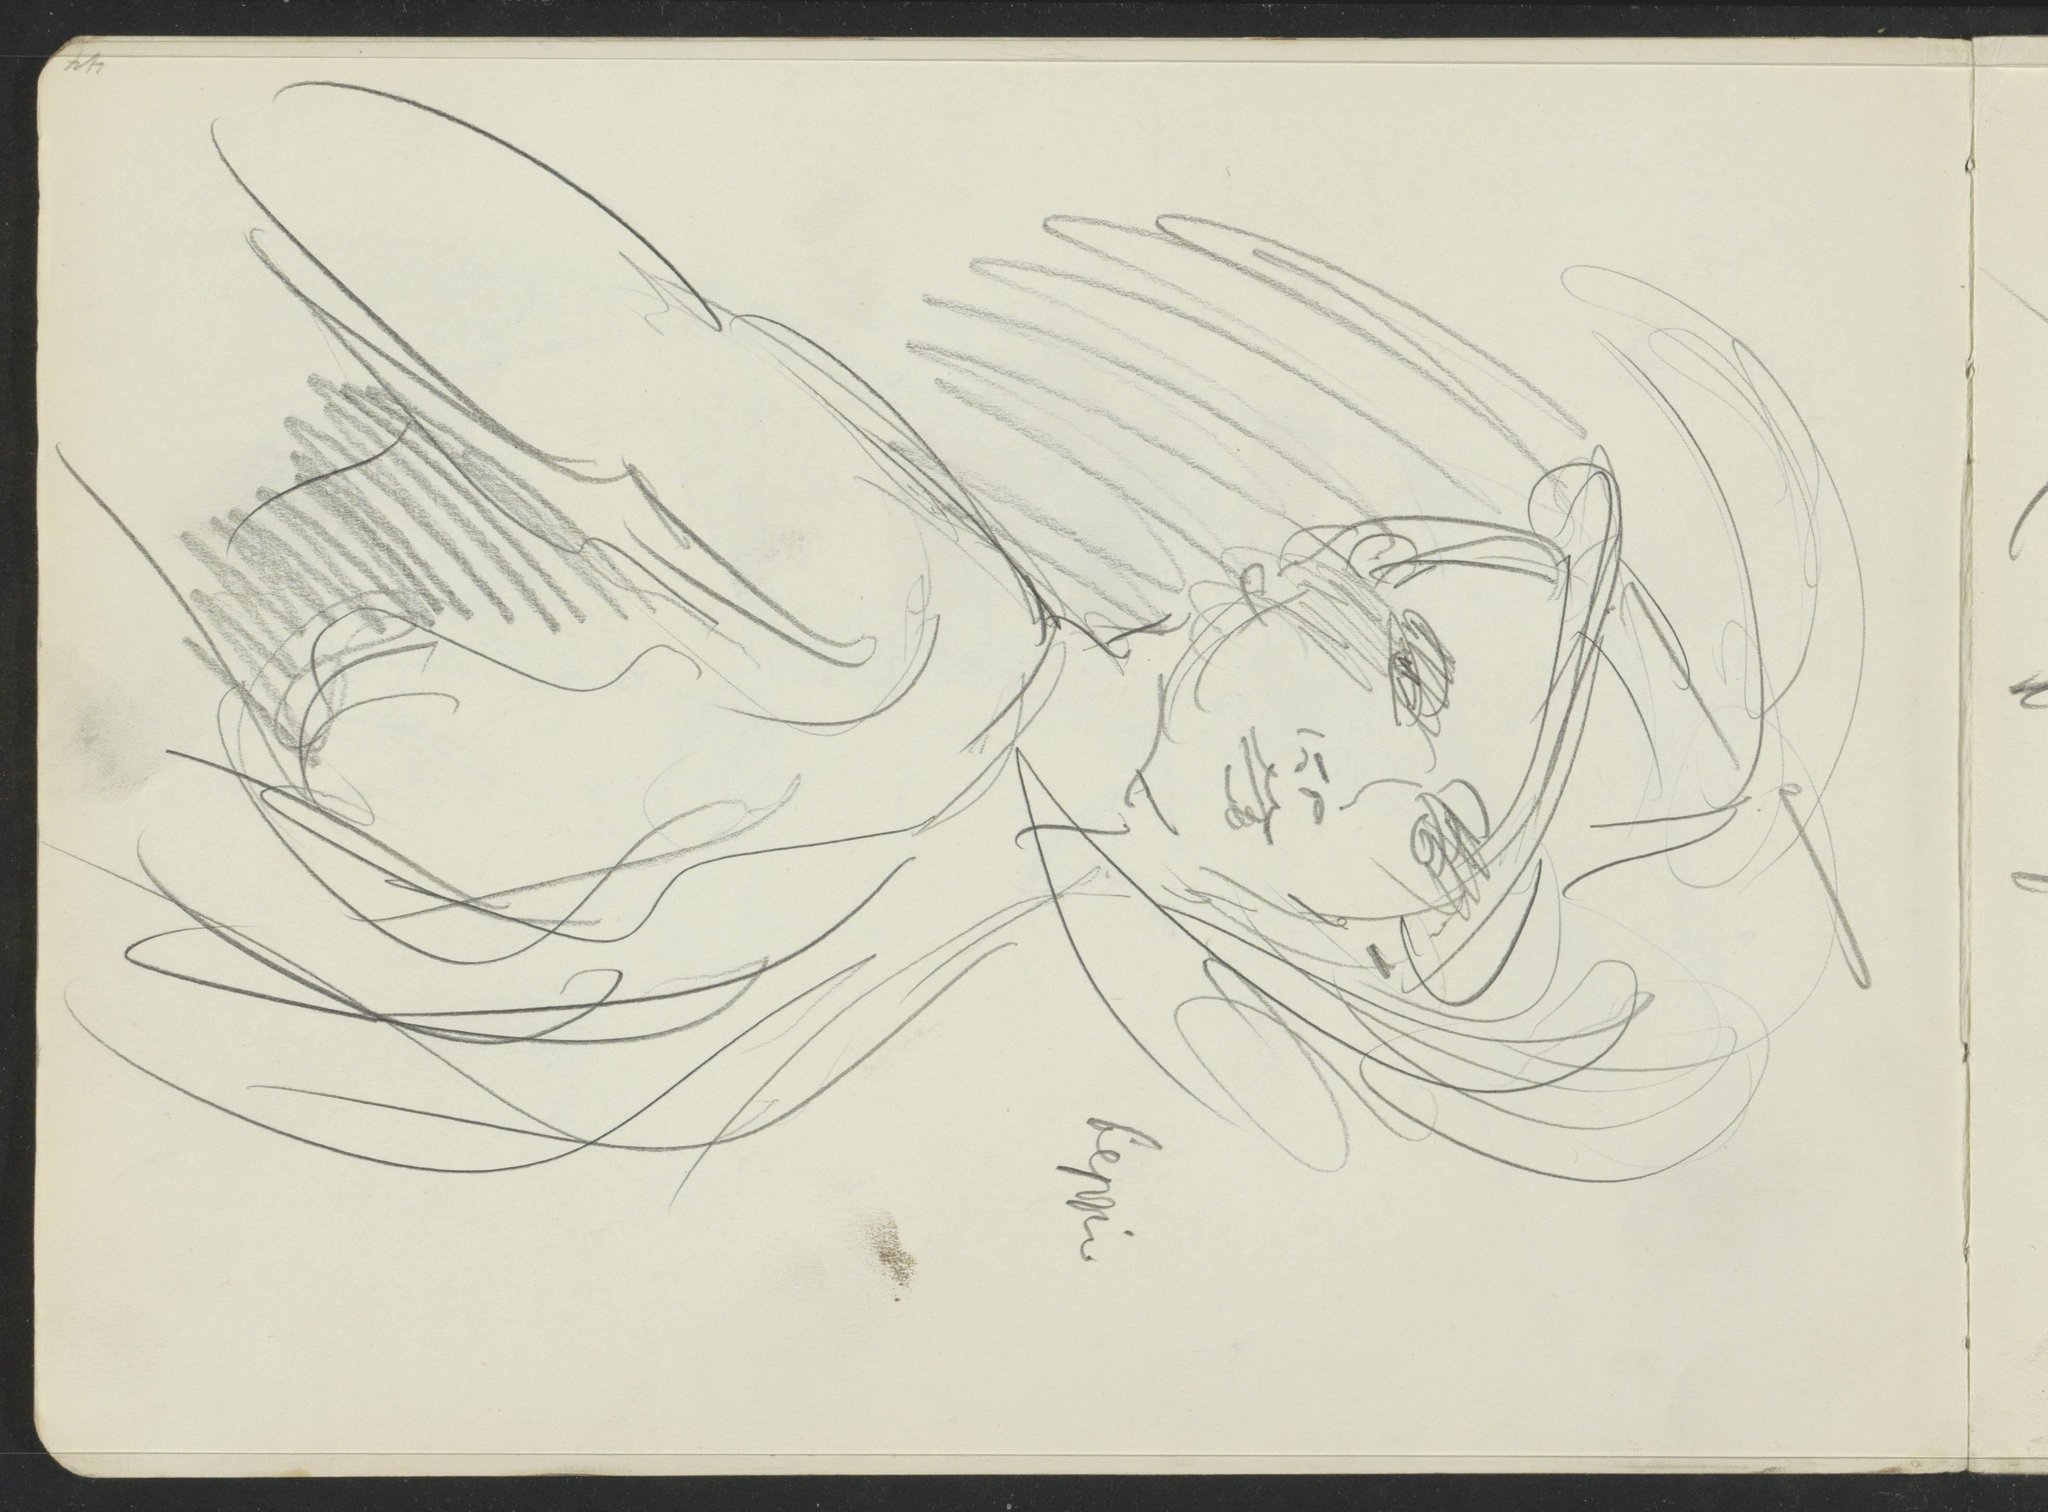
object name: sketchbook leaf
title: Portret van Beppie met hoed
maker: isaac israels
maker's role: draughtsman, painter, print maker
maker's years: 1865-1934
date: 1915-1934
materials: paper, pencil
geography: the hague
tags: historical persons - bb - woman, head-gear: hat (+ women's clothes)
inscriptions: annotation: ‘beppie’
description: Blad 1 verso uit schetsboek XV met 22 bladen.